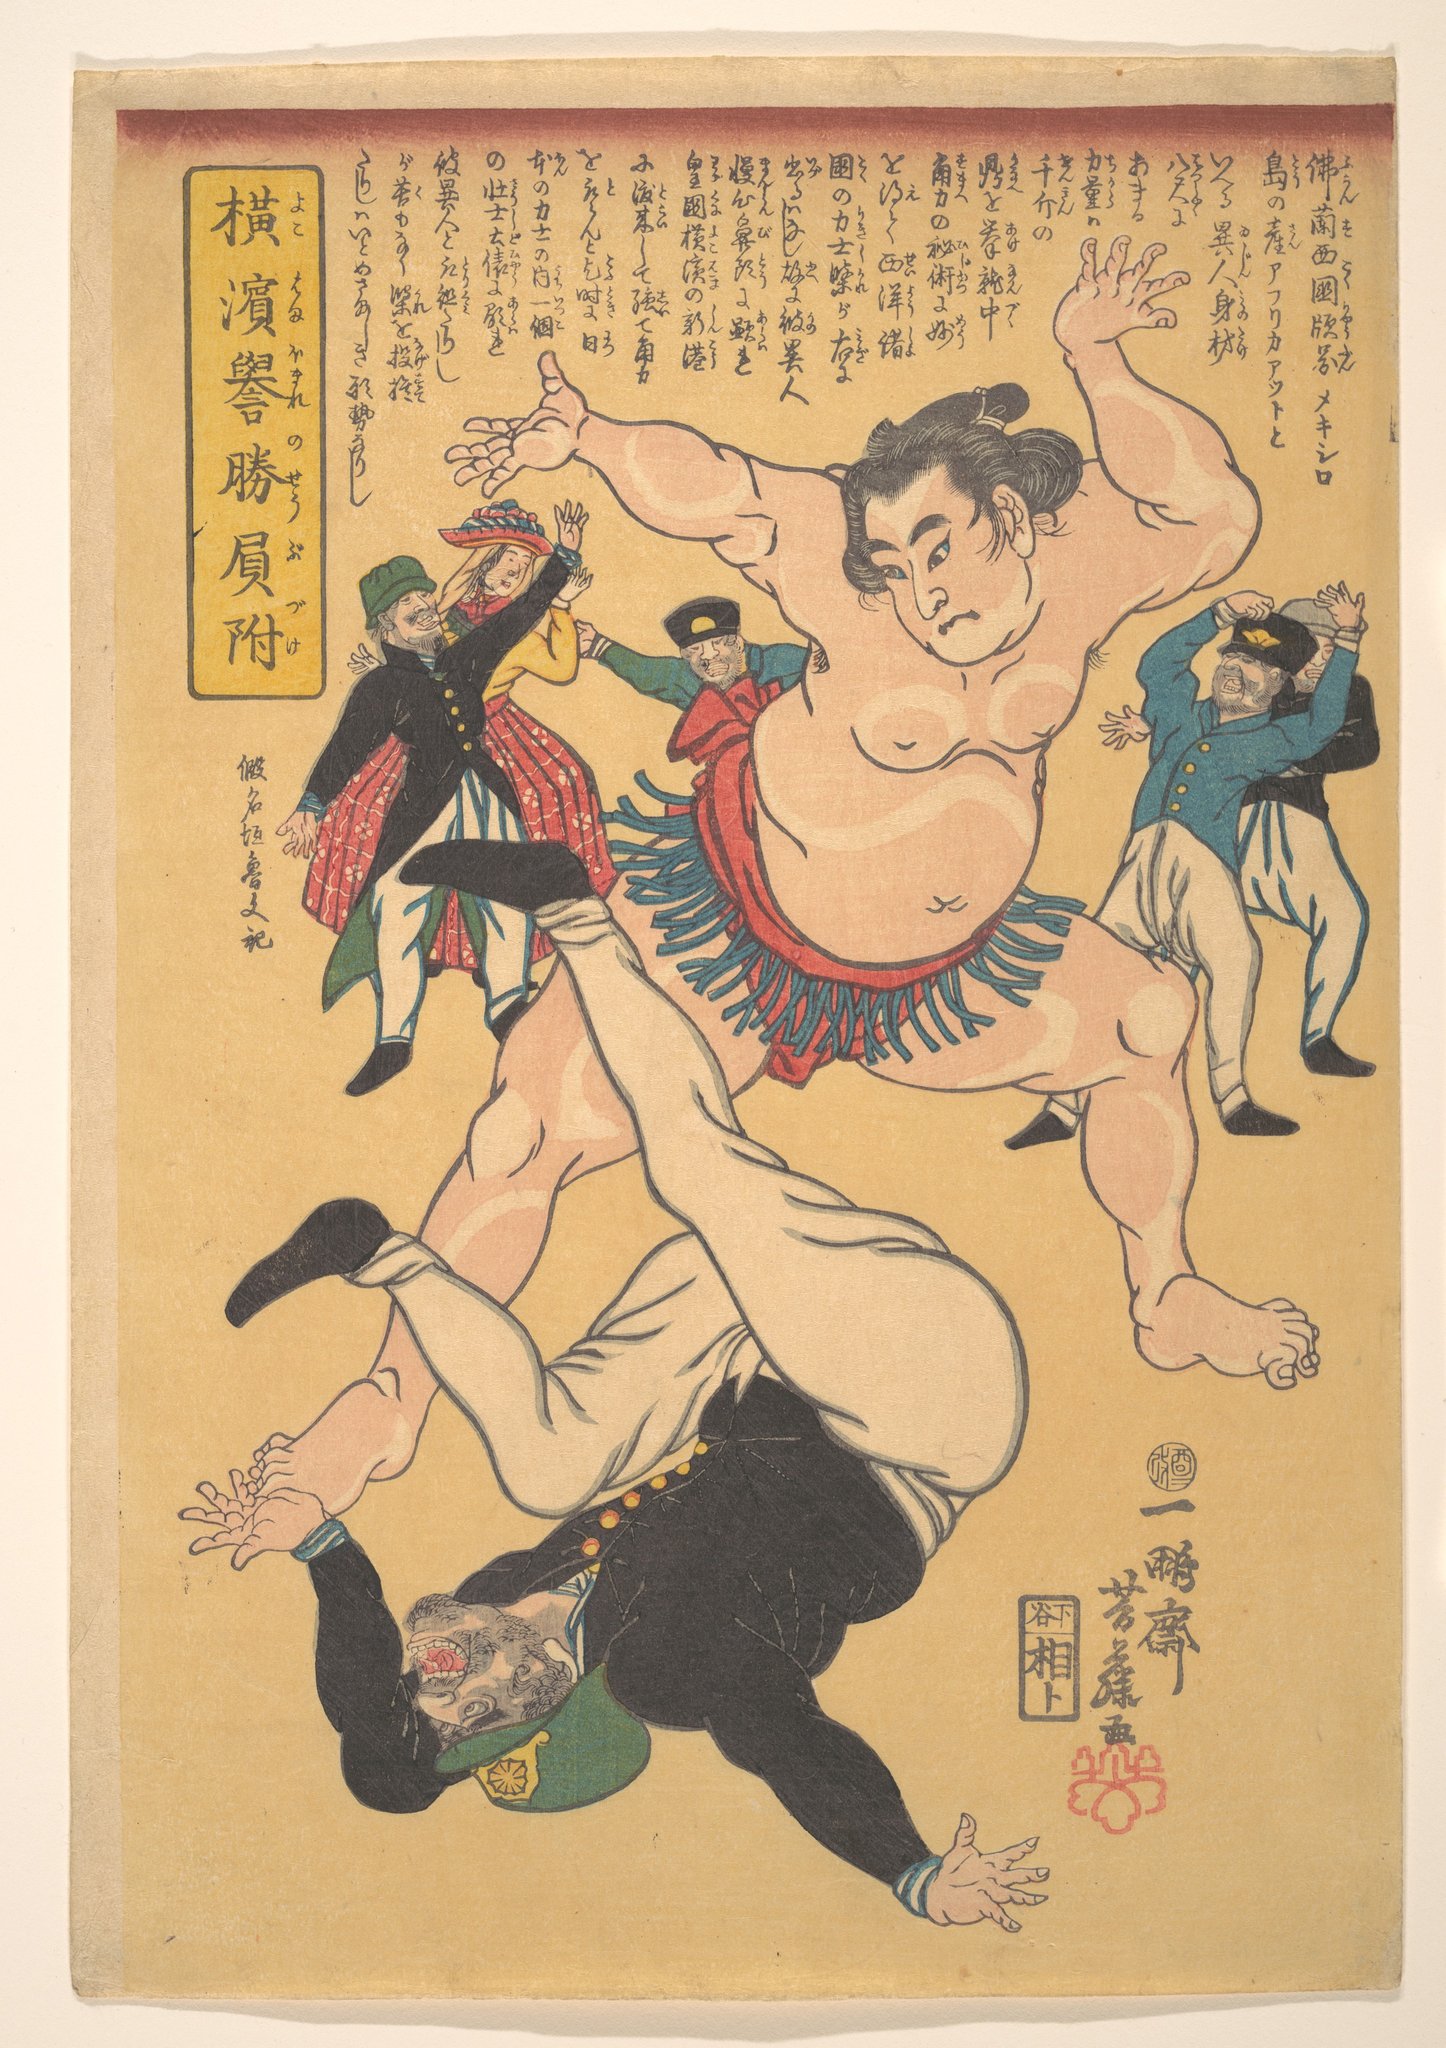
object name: print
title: Yokohama Sumo Wrestler Defeating a Foreigner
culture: japanese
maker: ippōsai yoshifuji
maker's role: artist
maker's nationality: japanese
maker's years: 1828-1887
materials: ink, paper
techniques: woodblock print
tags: men,sports